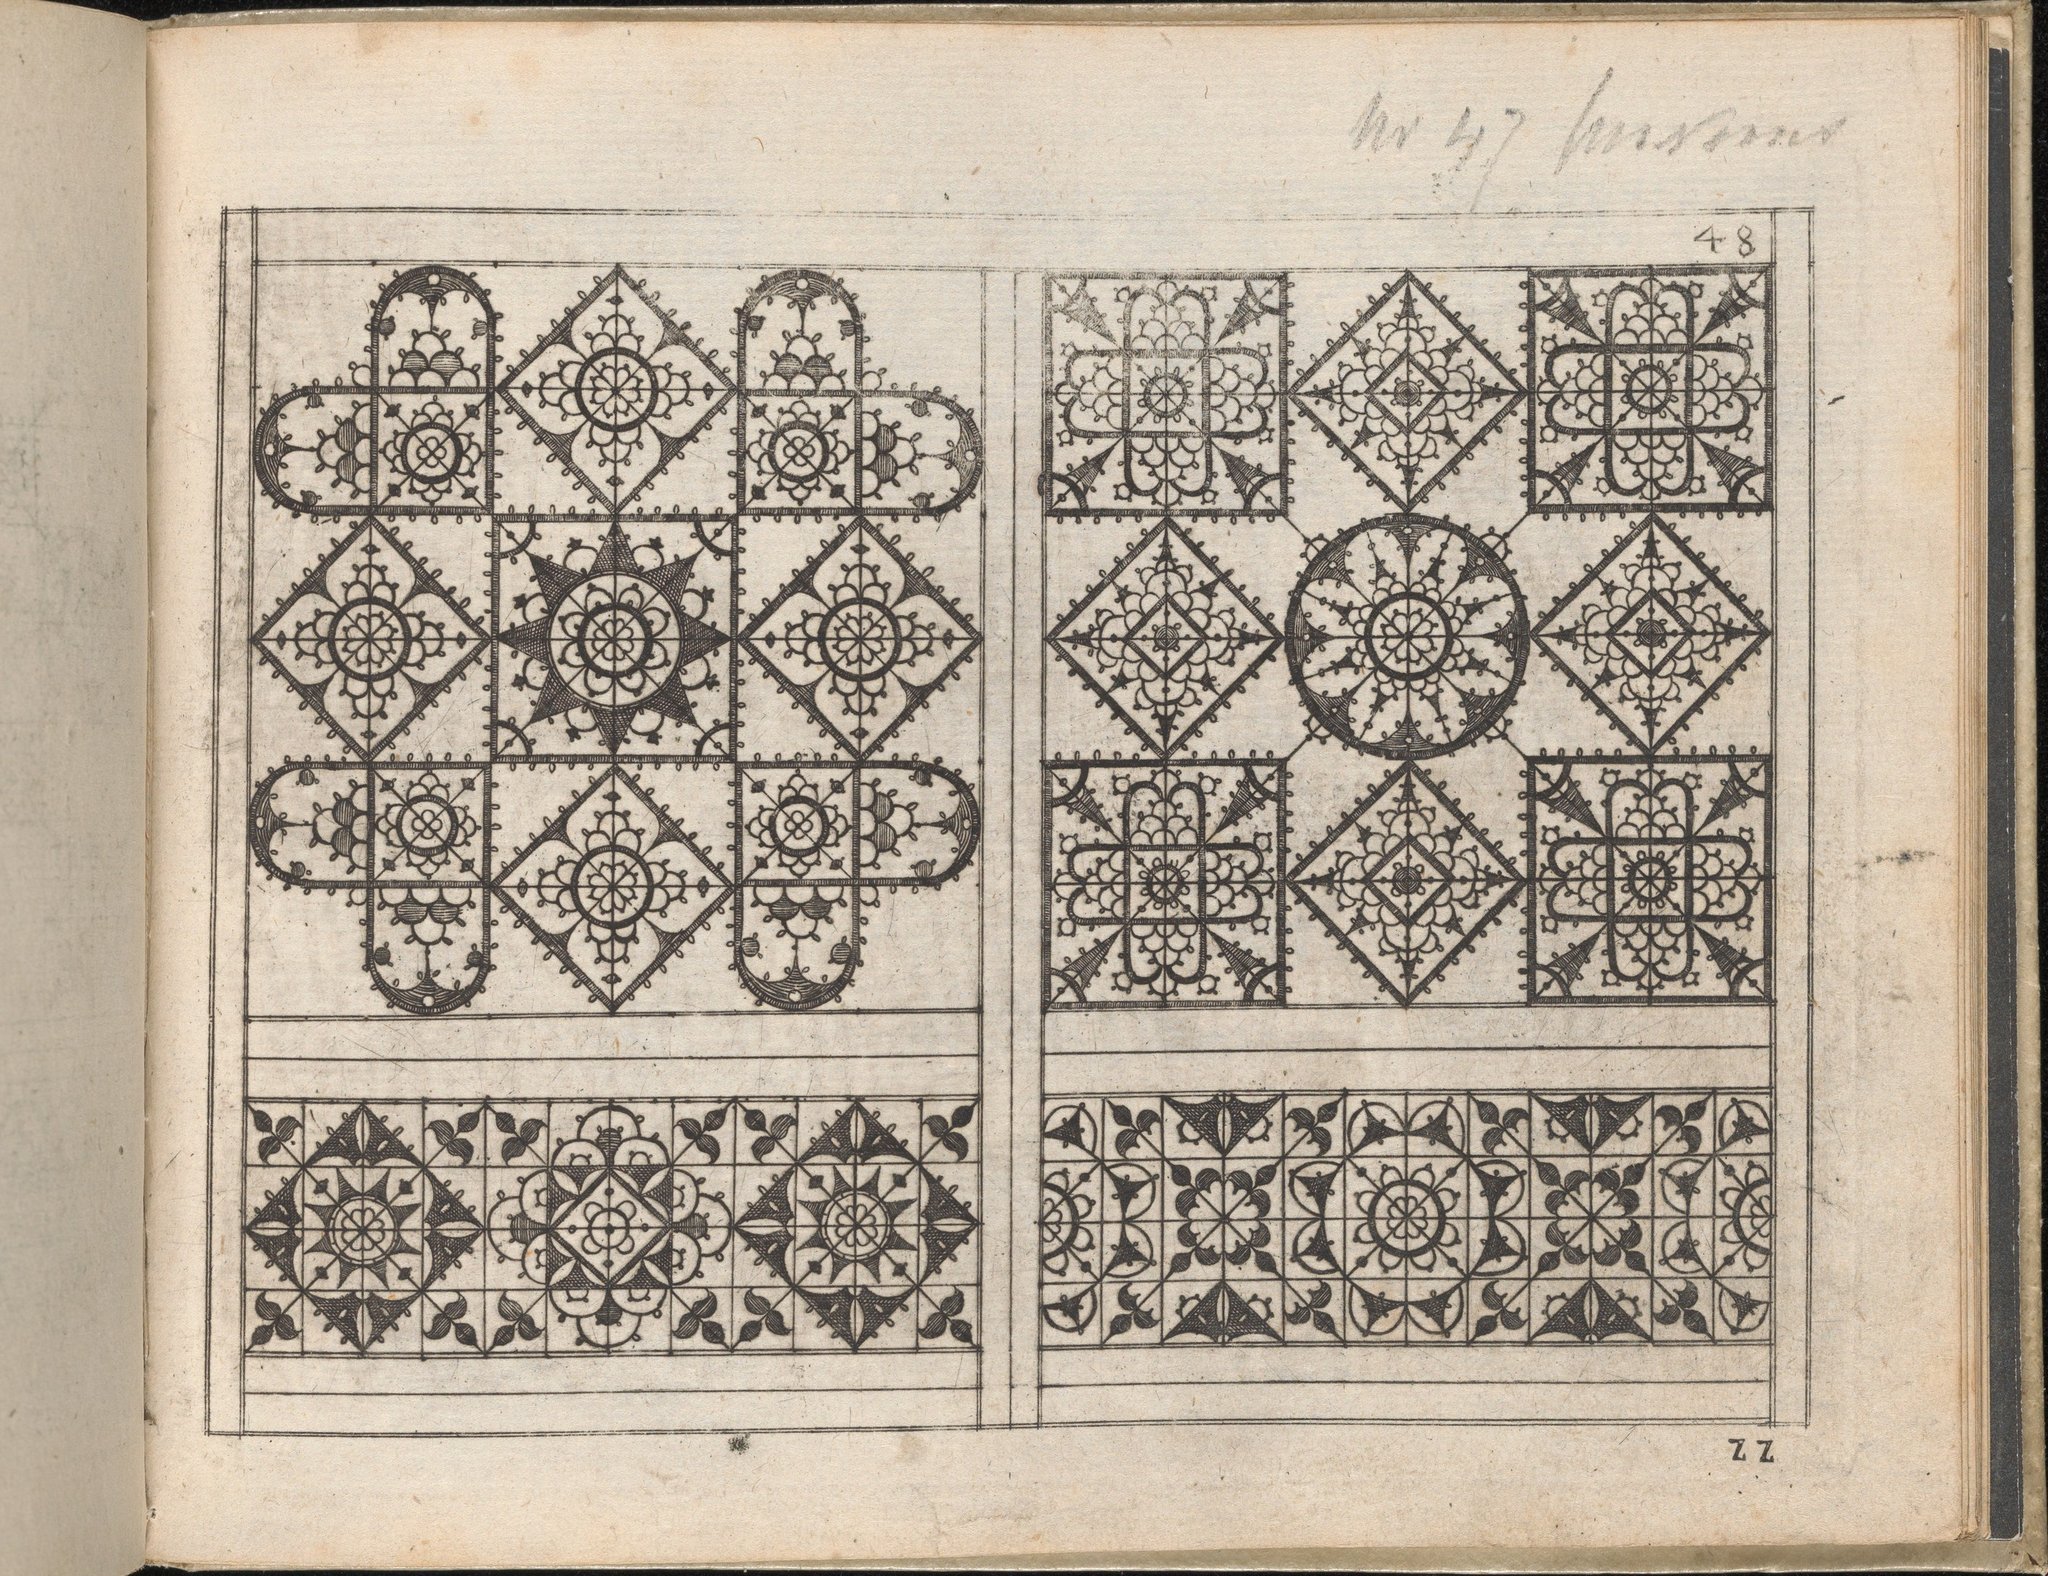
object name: book print ornament architecture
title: Newes Modelbuch in Kupffer (Page 56r)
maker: johann sibmacher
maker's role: artist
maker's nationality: german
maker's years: 1590-1611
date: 1604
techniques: etching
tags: ornament